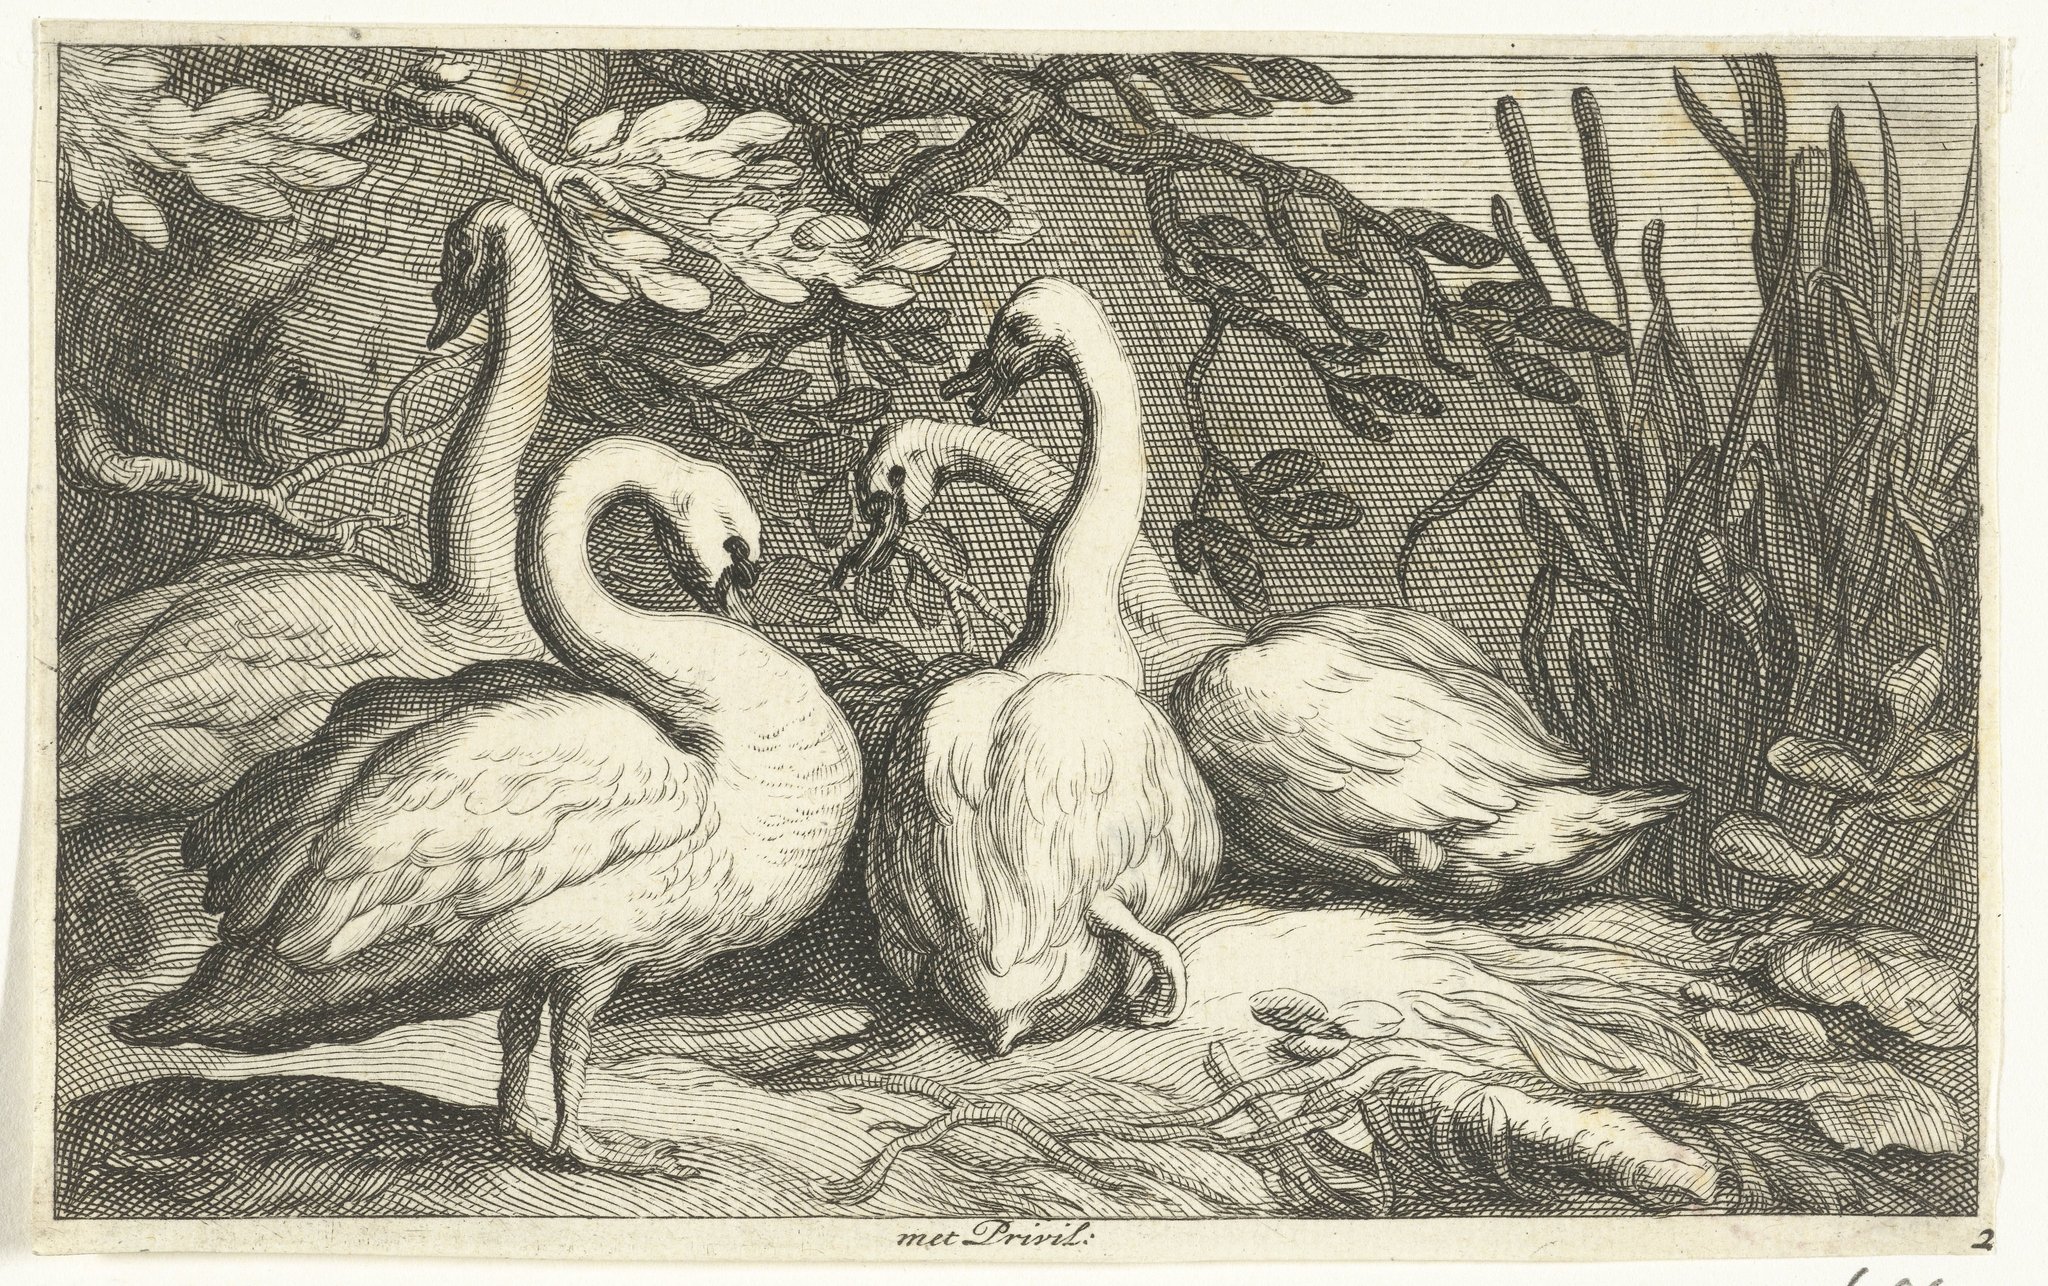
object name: print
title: Dieren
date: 1635-1670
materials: paper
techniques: engraving, etching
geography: amsterdam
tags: water-birds: swan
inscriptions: collector's mark: Lugt 240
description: Vier zwanen aan de waterkant tussen het riet. Prent uit een serie van 14 prenten met verschillende inheemse dieren.